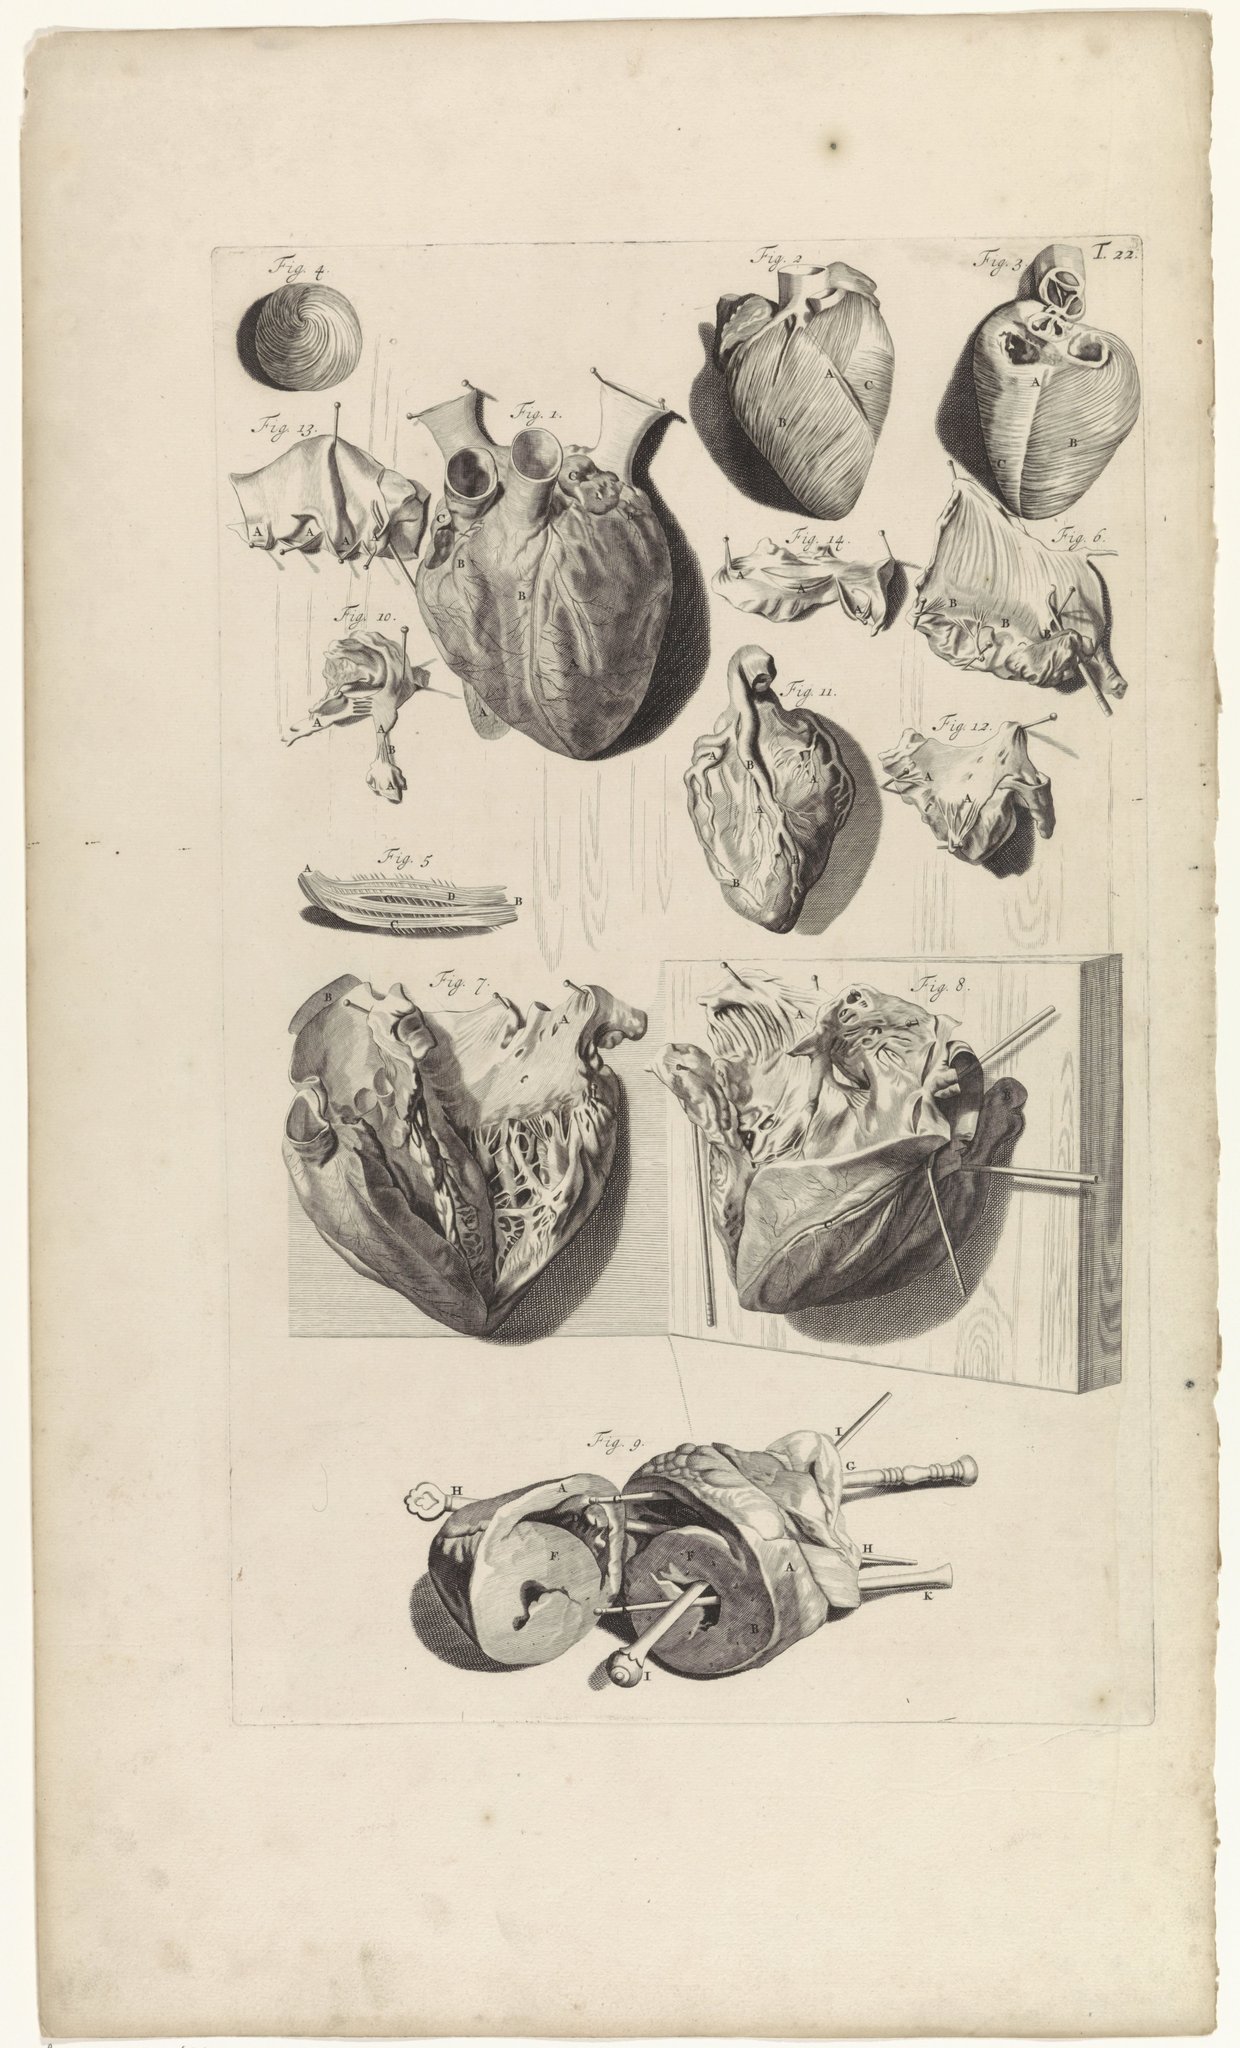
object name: print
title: Anatomische studie van het hart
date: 1685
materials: paper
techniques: engraving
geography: amsterdam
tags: parts of the heart, heart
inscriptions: collector's mark: Lugt 2228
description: Boekillustratie voor Bidloo, Godefridus. Anatomia humani corporis centum & quinque tabulis, per art. G. de Lairesse ad vivum delineatis, de monstrata, veterum recentiorumque inventis explicata plurimisque, hactenus non detectis, illustrata. Amsterdam: Weduwe Joannes van Someren, Hendrick Boom en erven Dirk Boom, 1685.